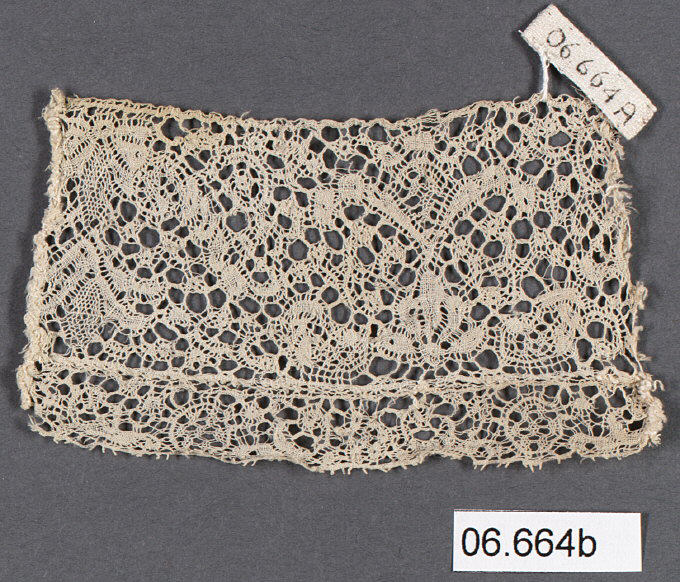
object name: fragment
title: Fragment of bobbin lace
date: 1700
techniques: lace